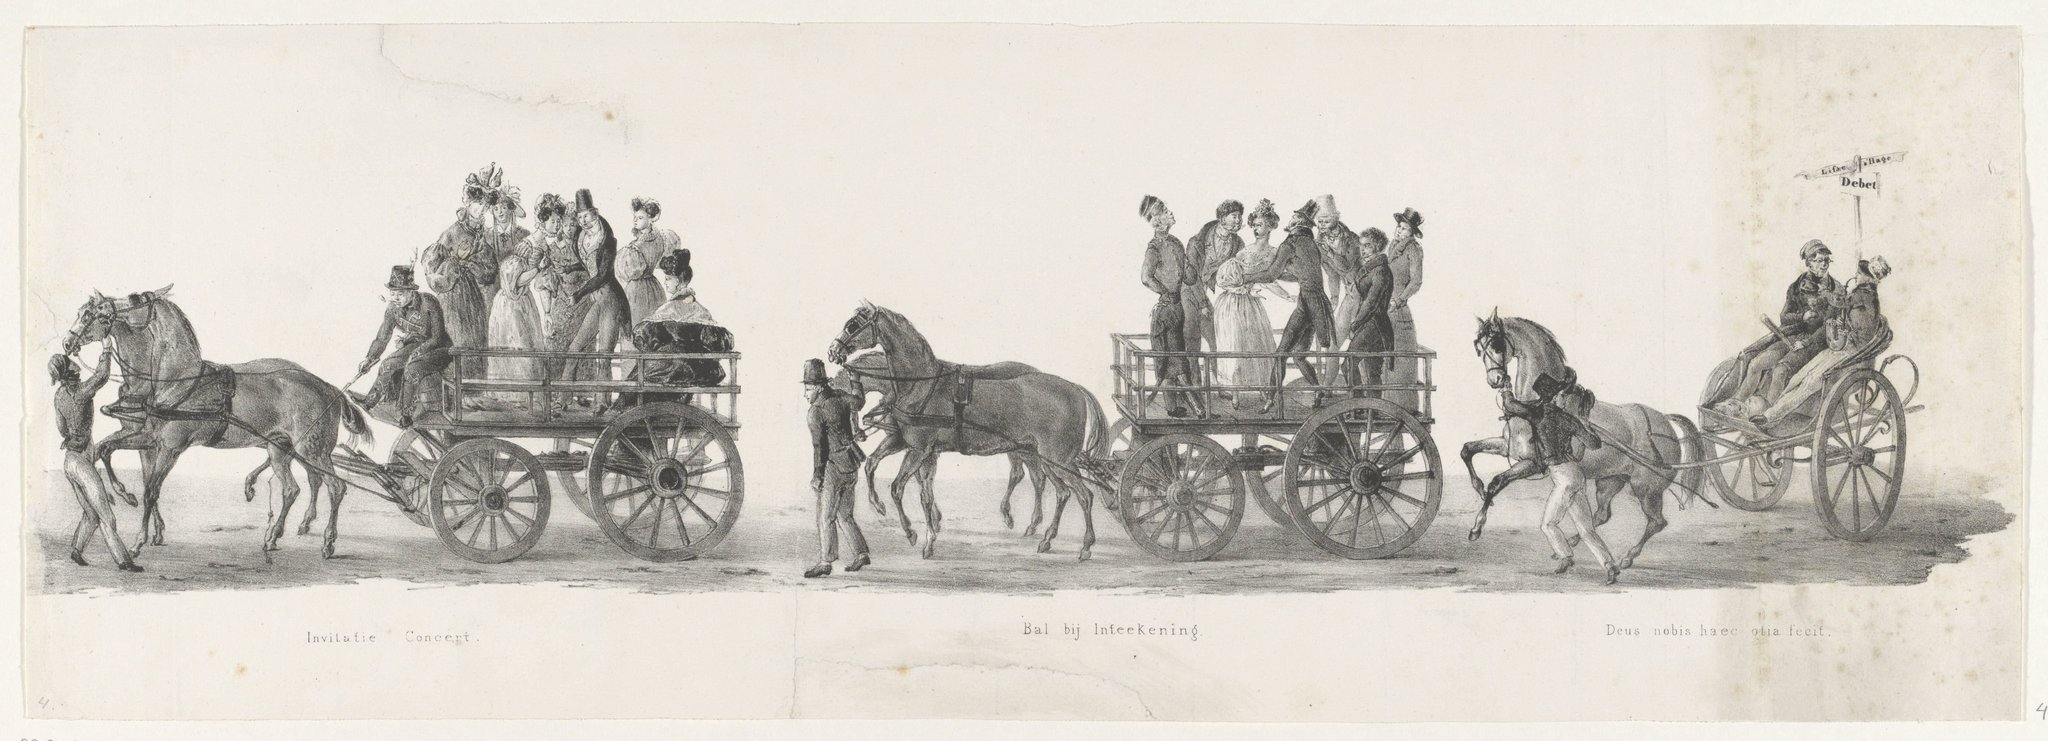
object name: print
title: Uitnodiging voor een concert, de bal en dronken studenten, 1835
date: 1835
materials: paper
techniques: lithograph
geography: leiden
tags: students' pageant, commemoration of the founding of a university, student life, leiden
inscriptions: collector's mark: Lugt 2228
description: Blad met drie karren. Op de eerste kar nodigt een man vrouwen uit voor een concert. Op de tweede kar een vrouw omringd door mannen op een bal. Achteraan een sjees met twee dronken studenten. Vierde plaat in de optocht gehouden door studenten van de Leidse Hogeschool ter viering van de dies natalis van de universiteit op 9 februari 1835.